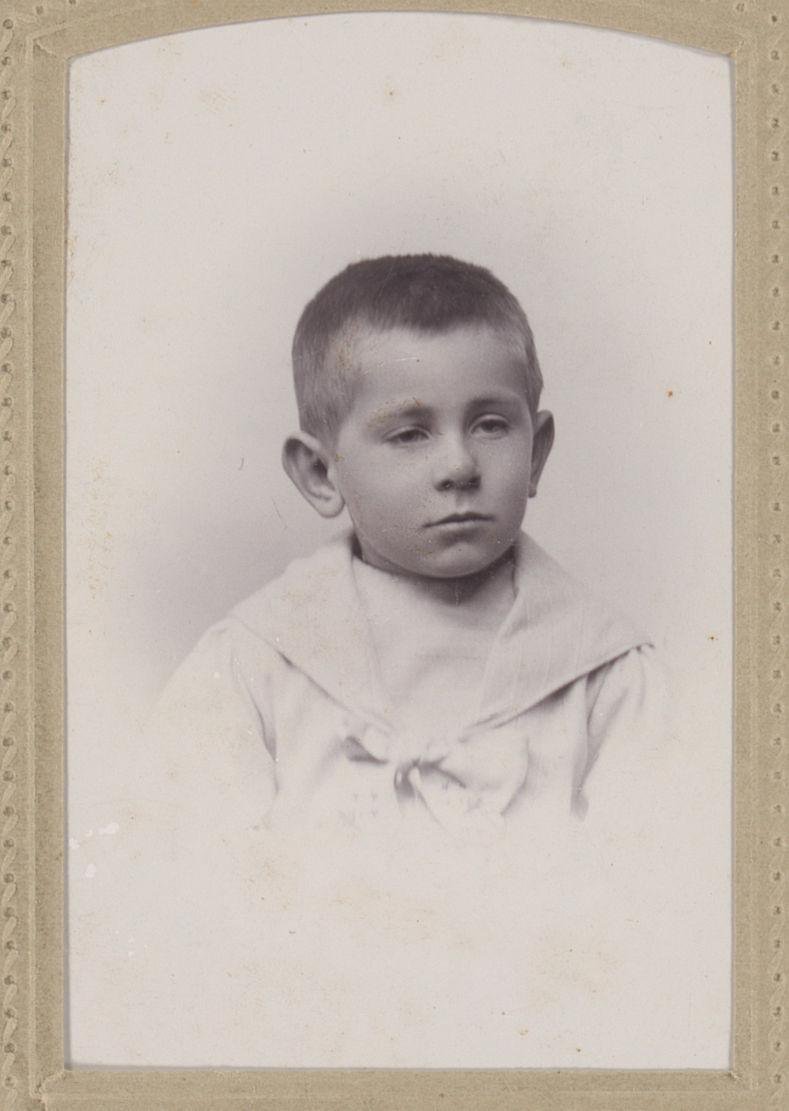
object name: photograph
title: Studioportret van Guus Kessler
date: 1893-1895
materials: paper, photographic support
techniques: collodion silver print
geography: netherlands